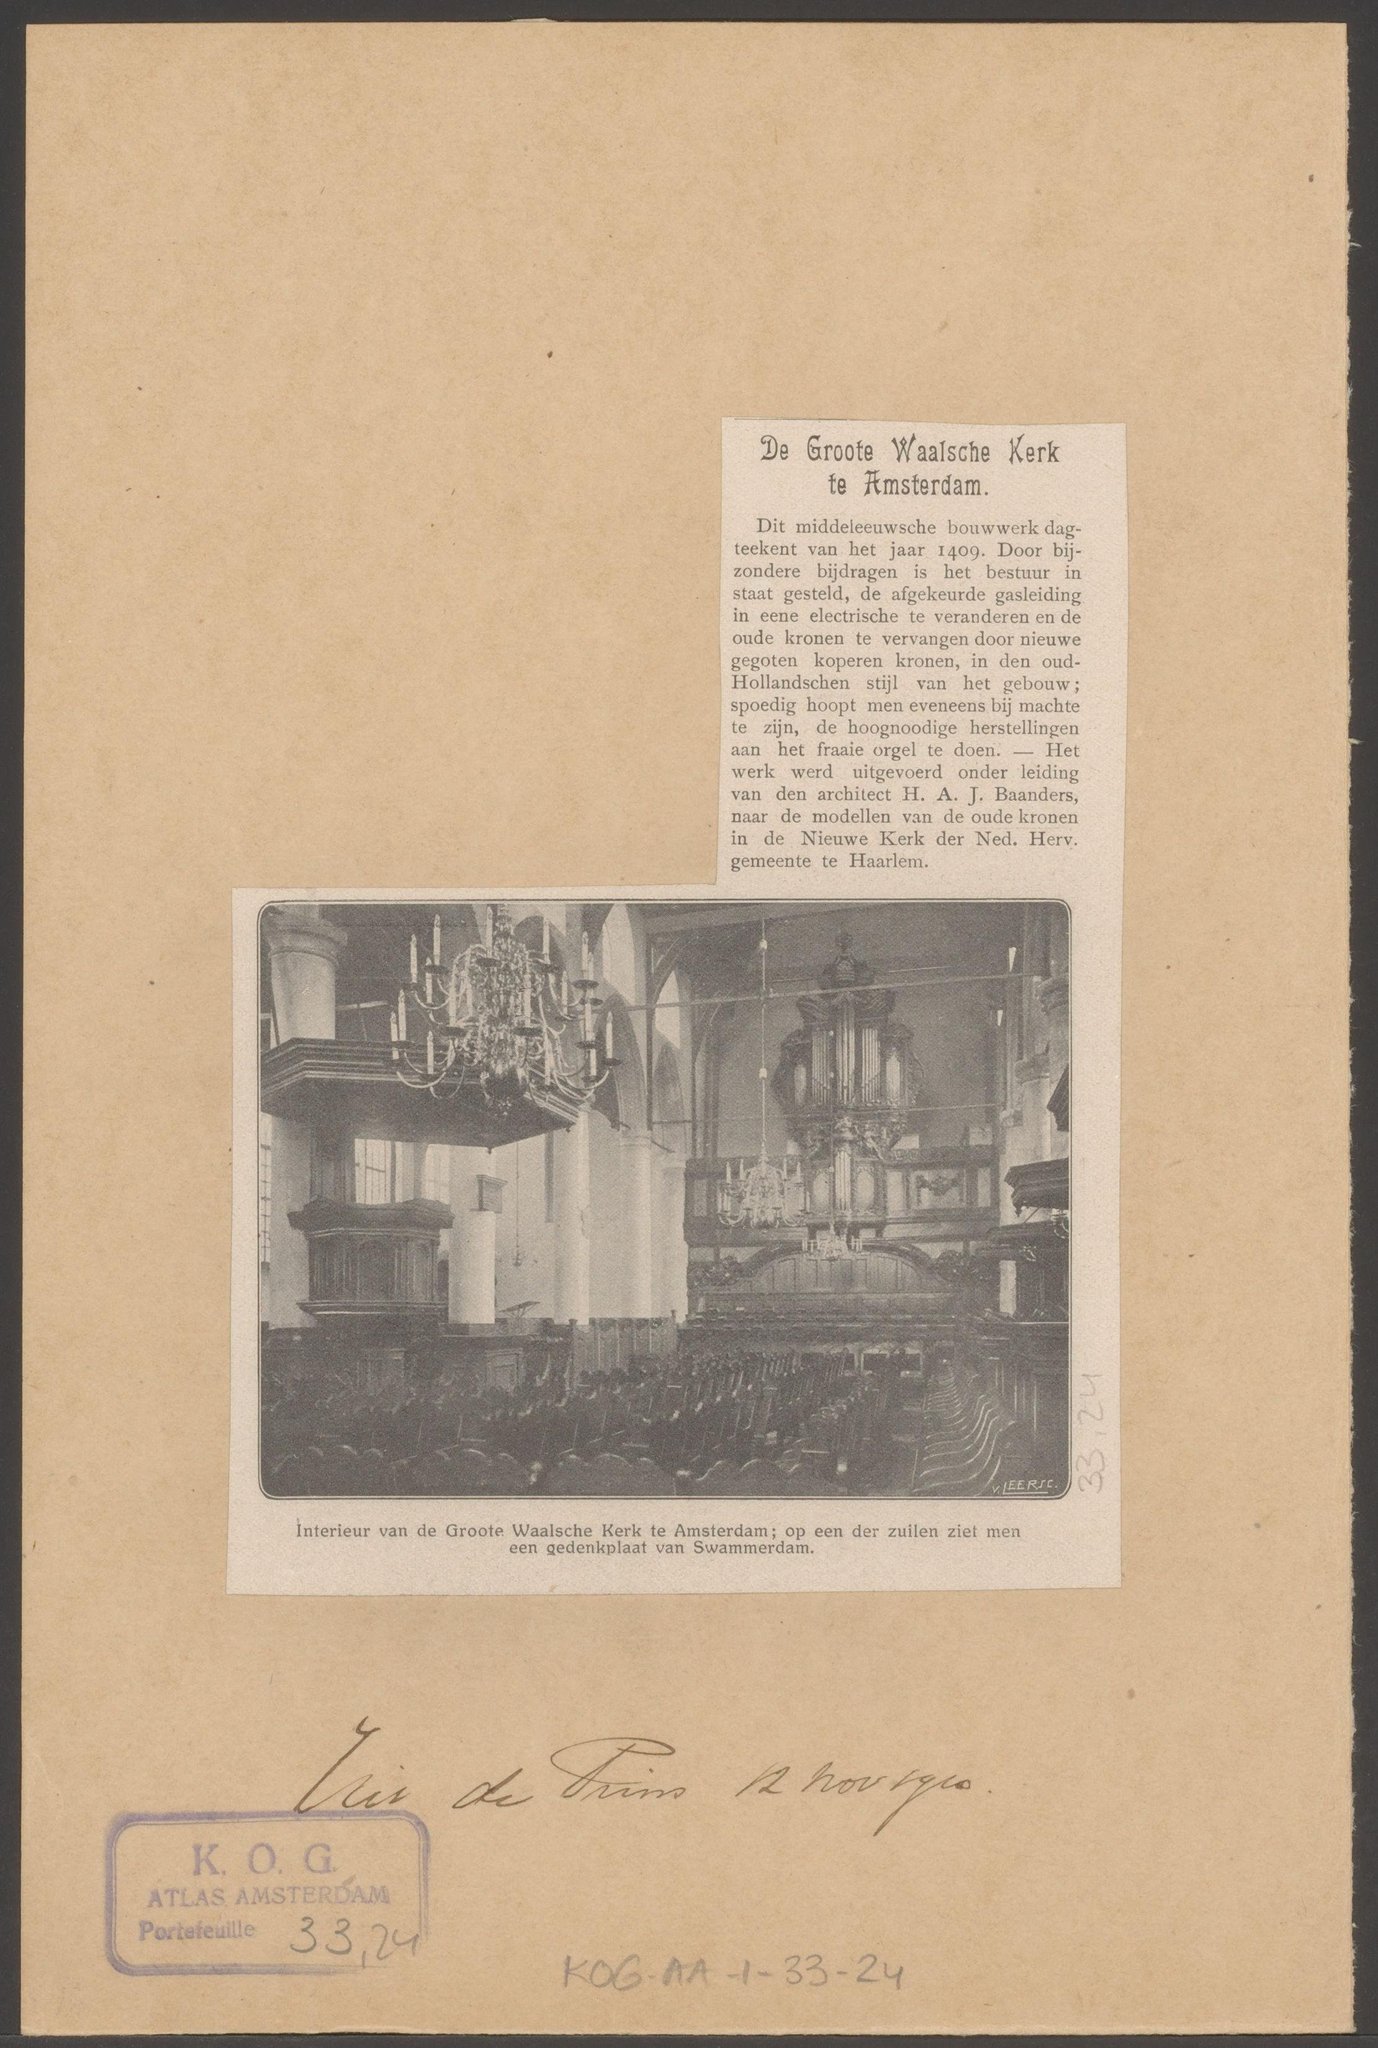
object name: photomechanical print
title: Interieur van de Waalse Kerk te Amsterdam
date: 1910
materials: paper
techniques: letterpress printing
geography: amsterdam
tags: interior of church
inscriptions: collector's mark: Lugt 1641b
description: Onderwerpsrubriek binnen de Atlas Amsterdam: Kerkwezen: Hervormde Gemeente: Waalse Gemeente.